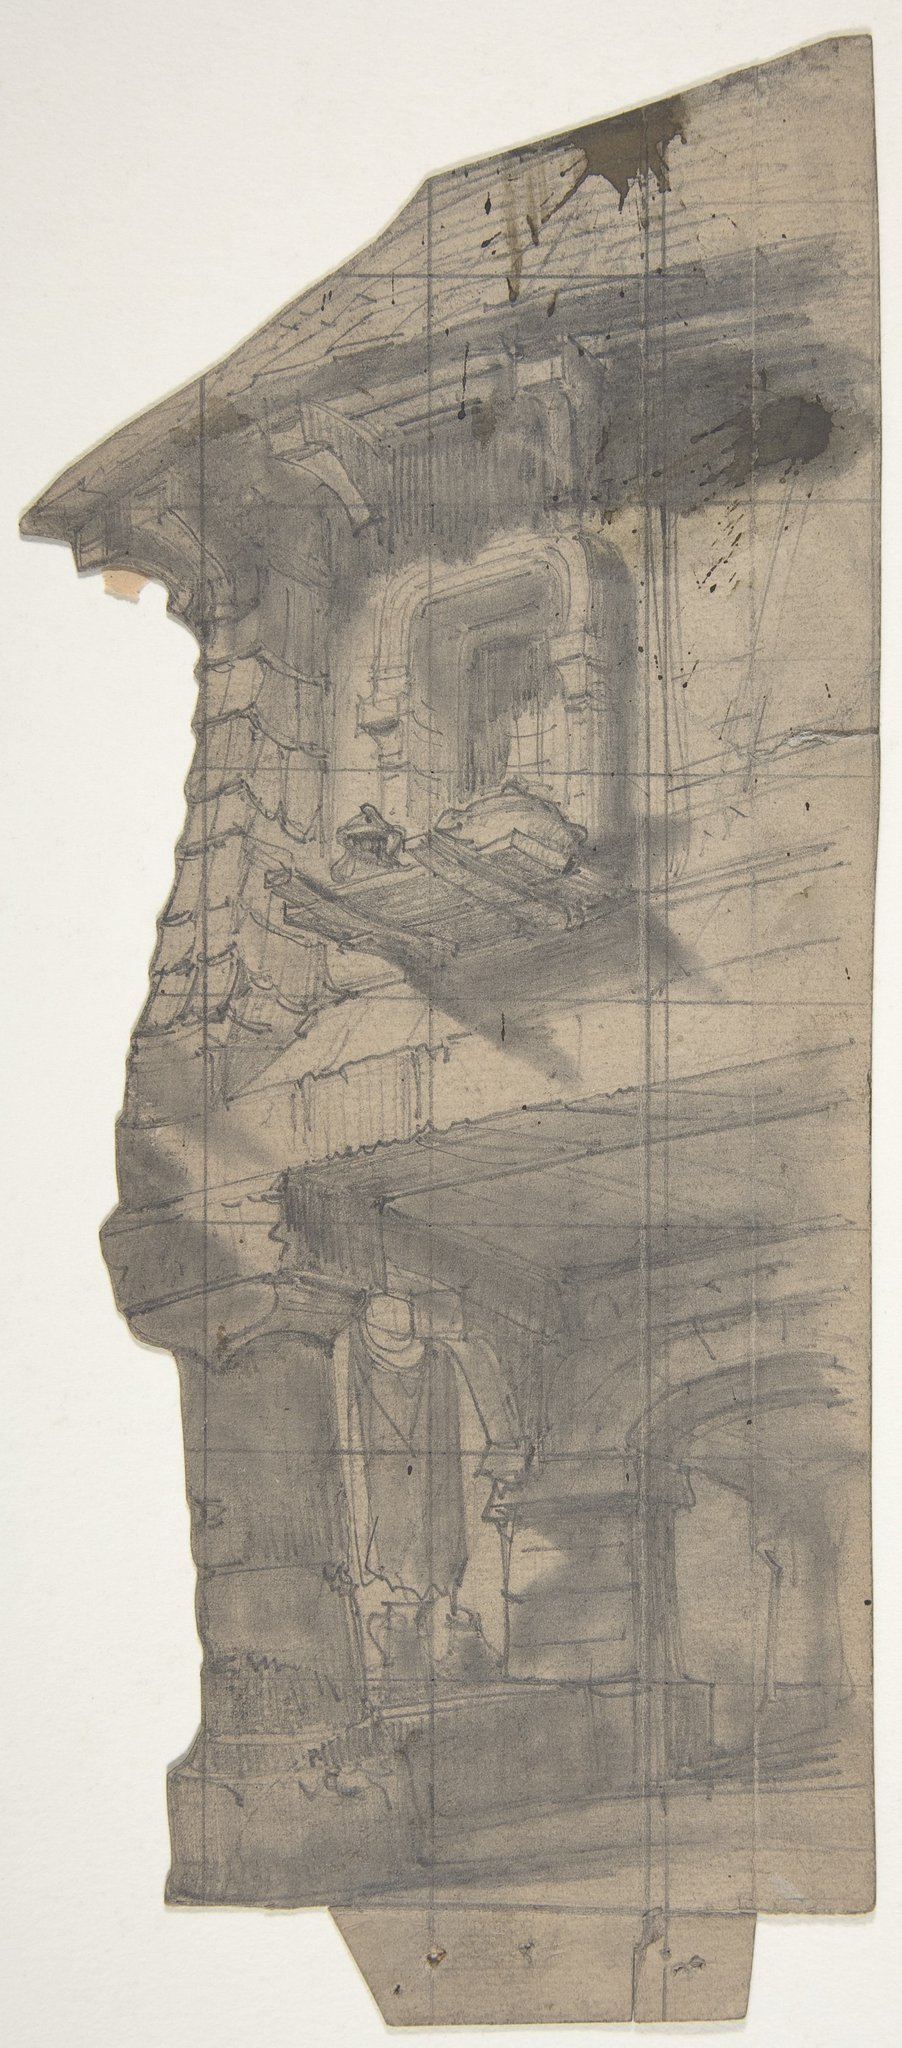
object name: drawing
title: Design for a Stage Set at the Opéra, Paris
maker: eugène cicéri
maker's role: artist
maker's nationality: french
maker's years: 1813-1890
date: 1830-1890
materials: graphite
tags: buildings,stage design